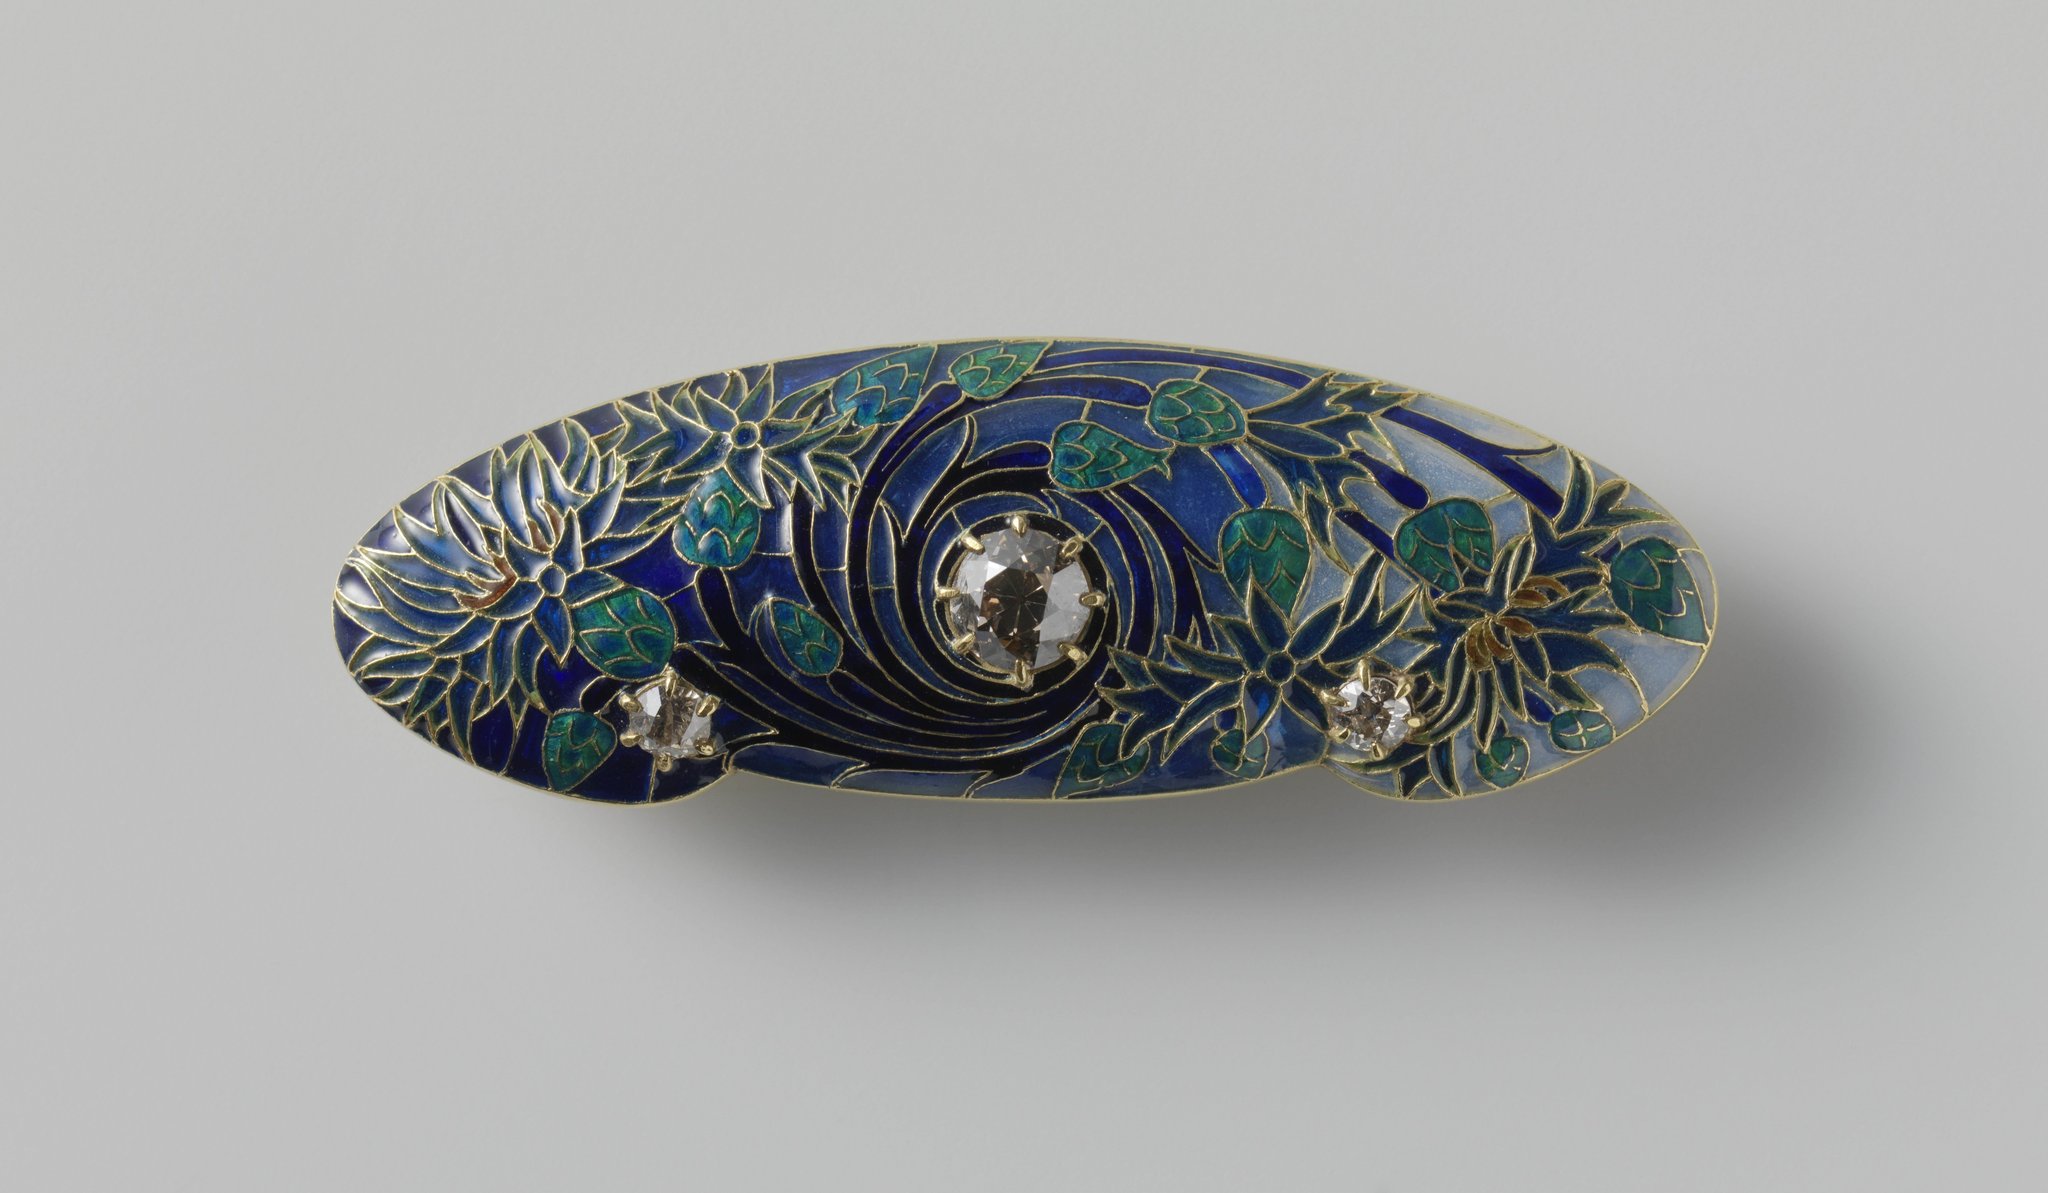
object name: jewellery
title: Broche met korenbloemen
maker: rené lalique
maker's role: jeweler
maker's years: 1860-1945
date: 1904-1906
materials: diamond, gold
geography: paris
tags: flowers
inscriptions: mark: ‘LALIQUE’, mark: ‘P[...] DÉPOSÉ’, maker's mark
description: Brooch.Gold, diamonds and enamel. Paris, c. 1904 - 1906, by René Lalique.